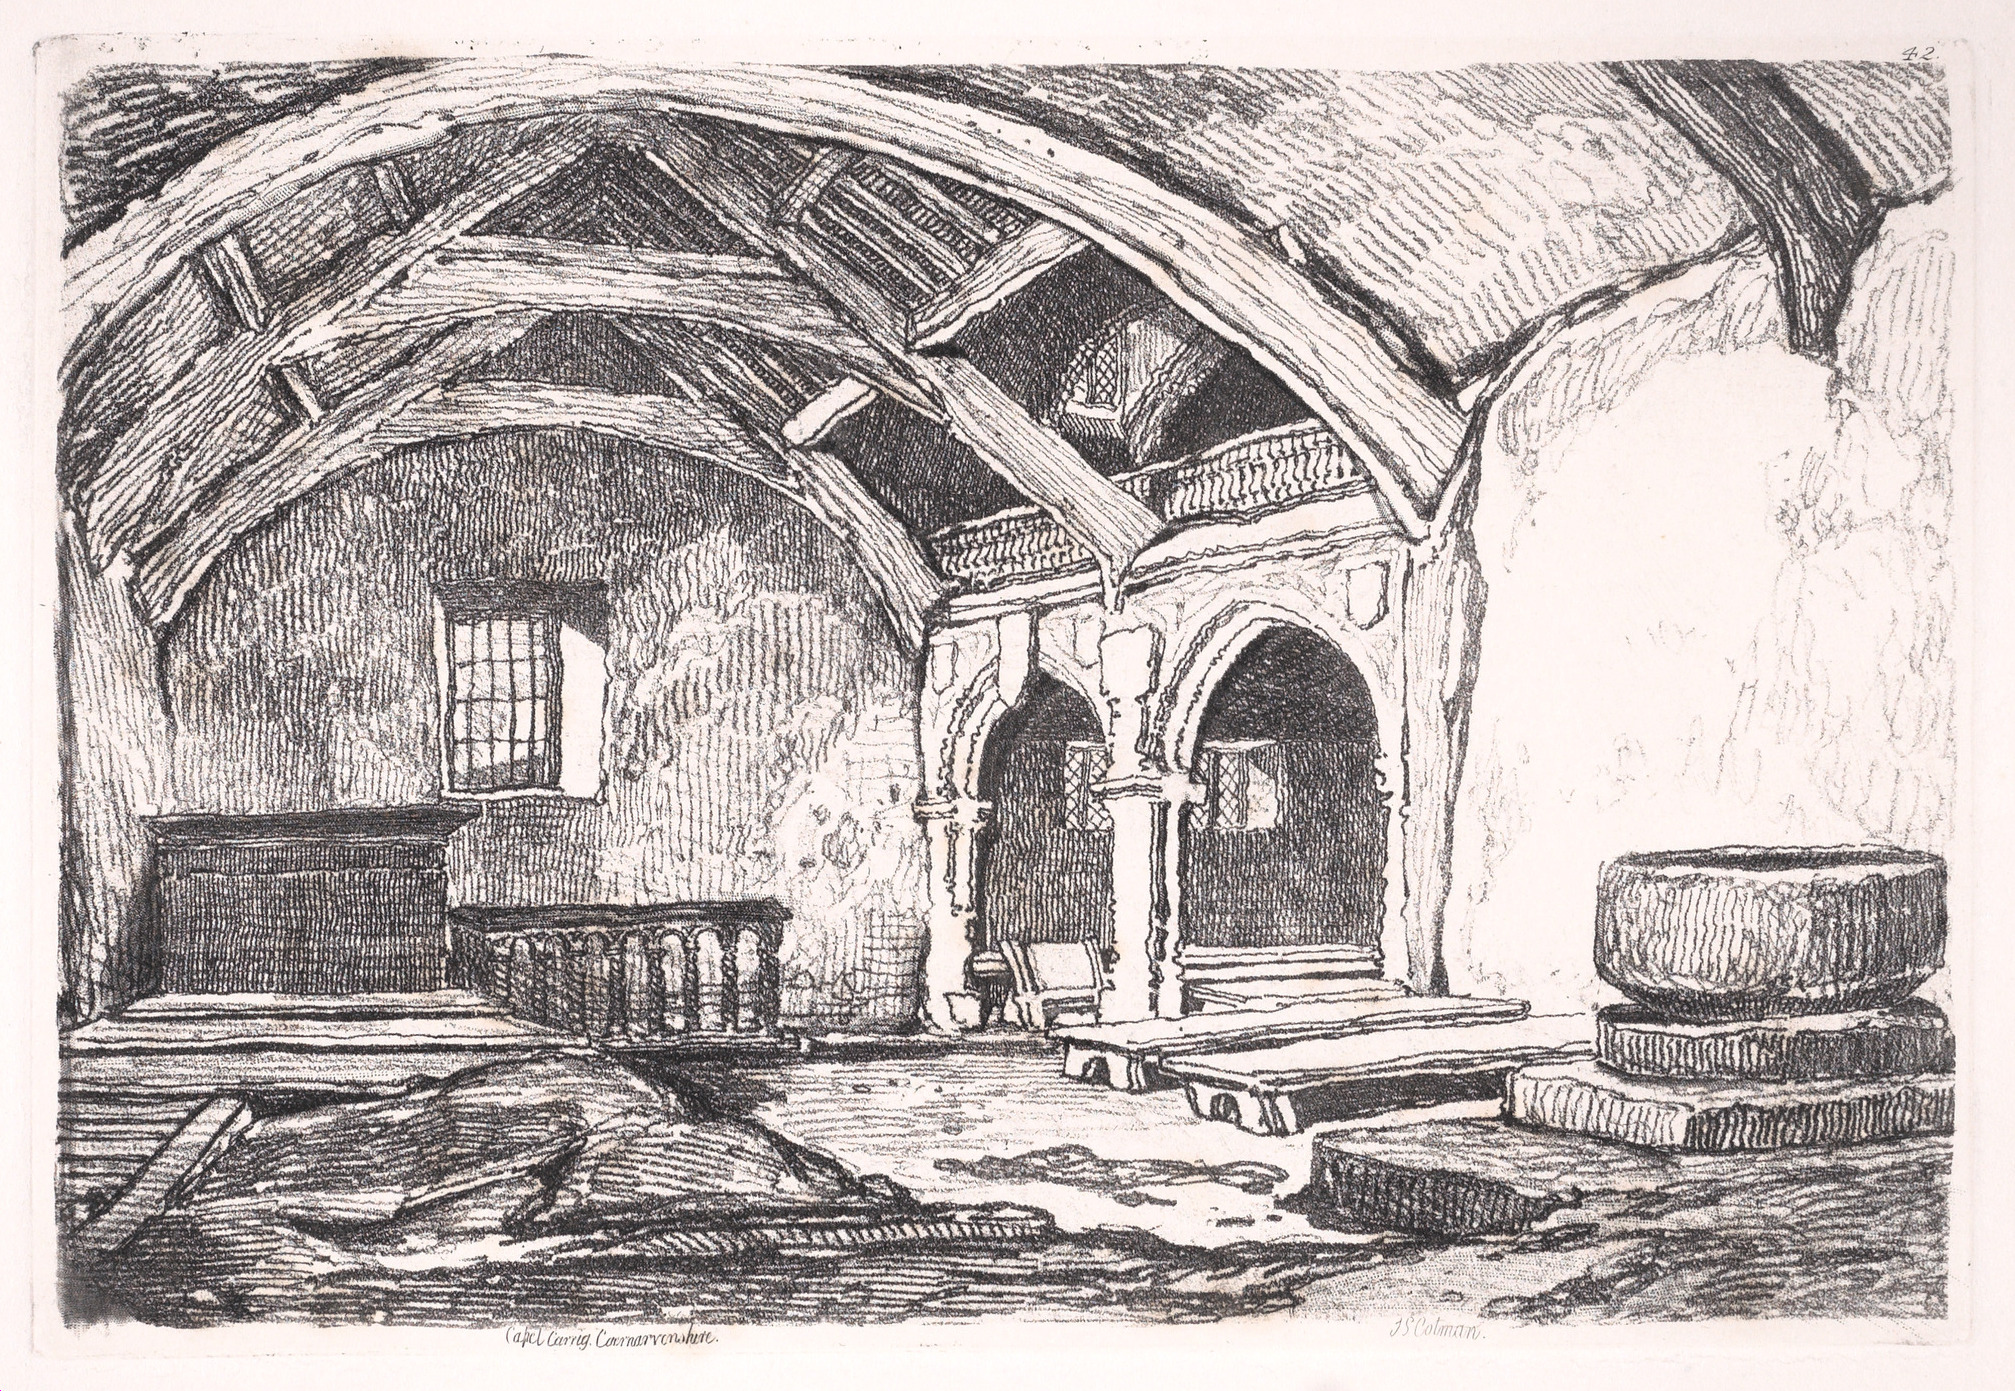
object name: print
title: Capel Carrig, Caernarvonshire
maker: john sell cotman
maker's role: artist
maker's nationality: british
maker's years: 1782-1842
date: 1838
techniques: etching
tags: interiors,chapels